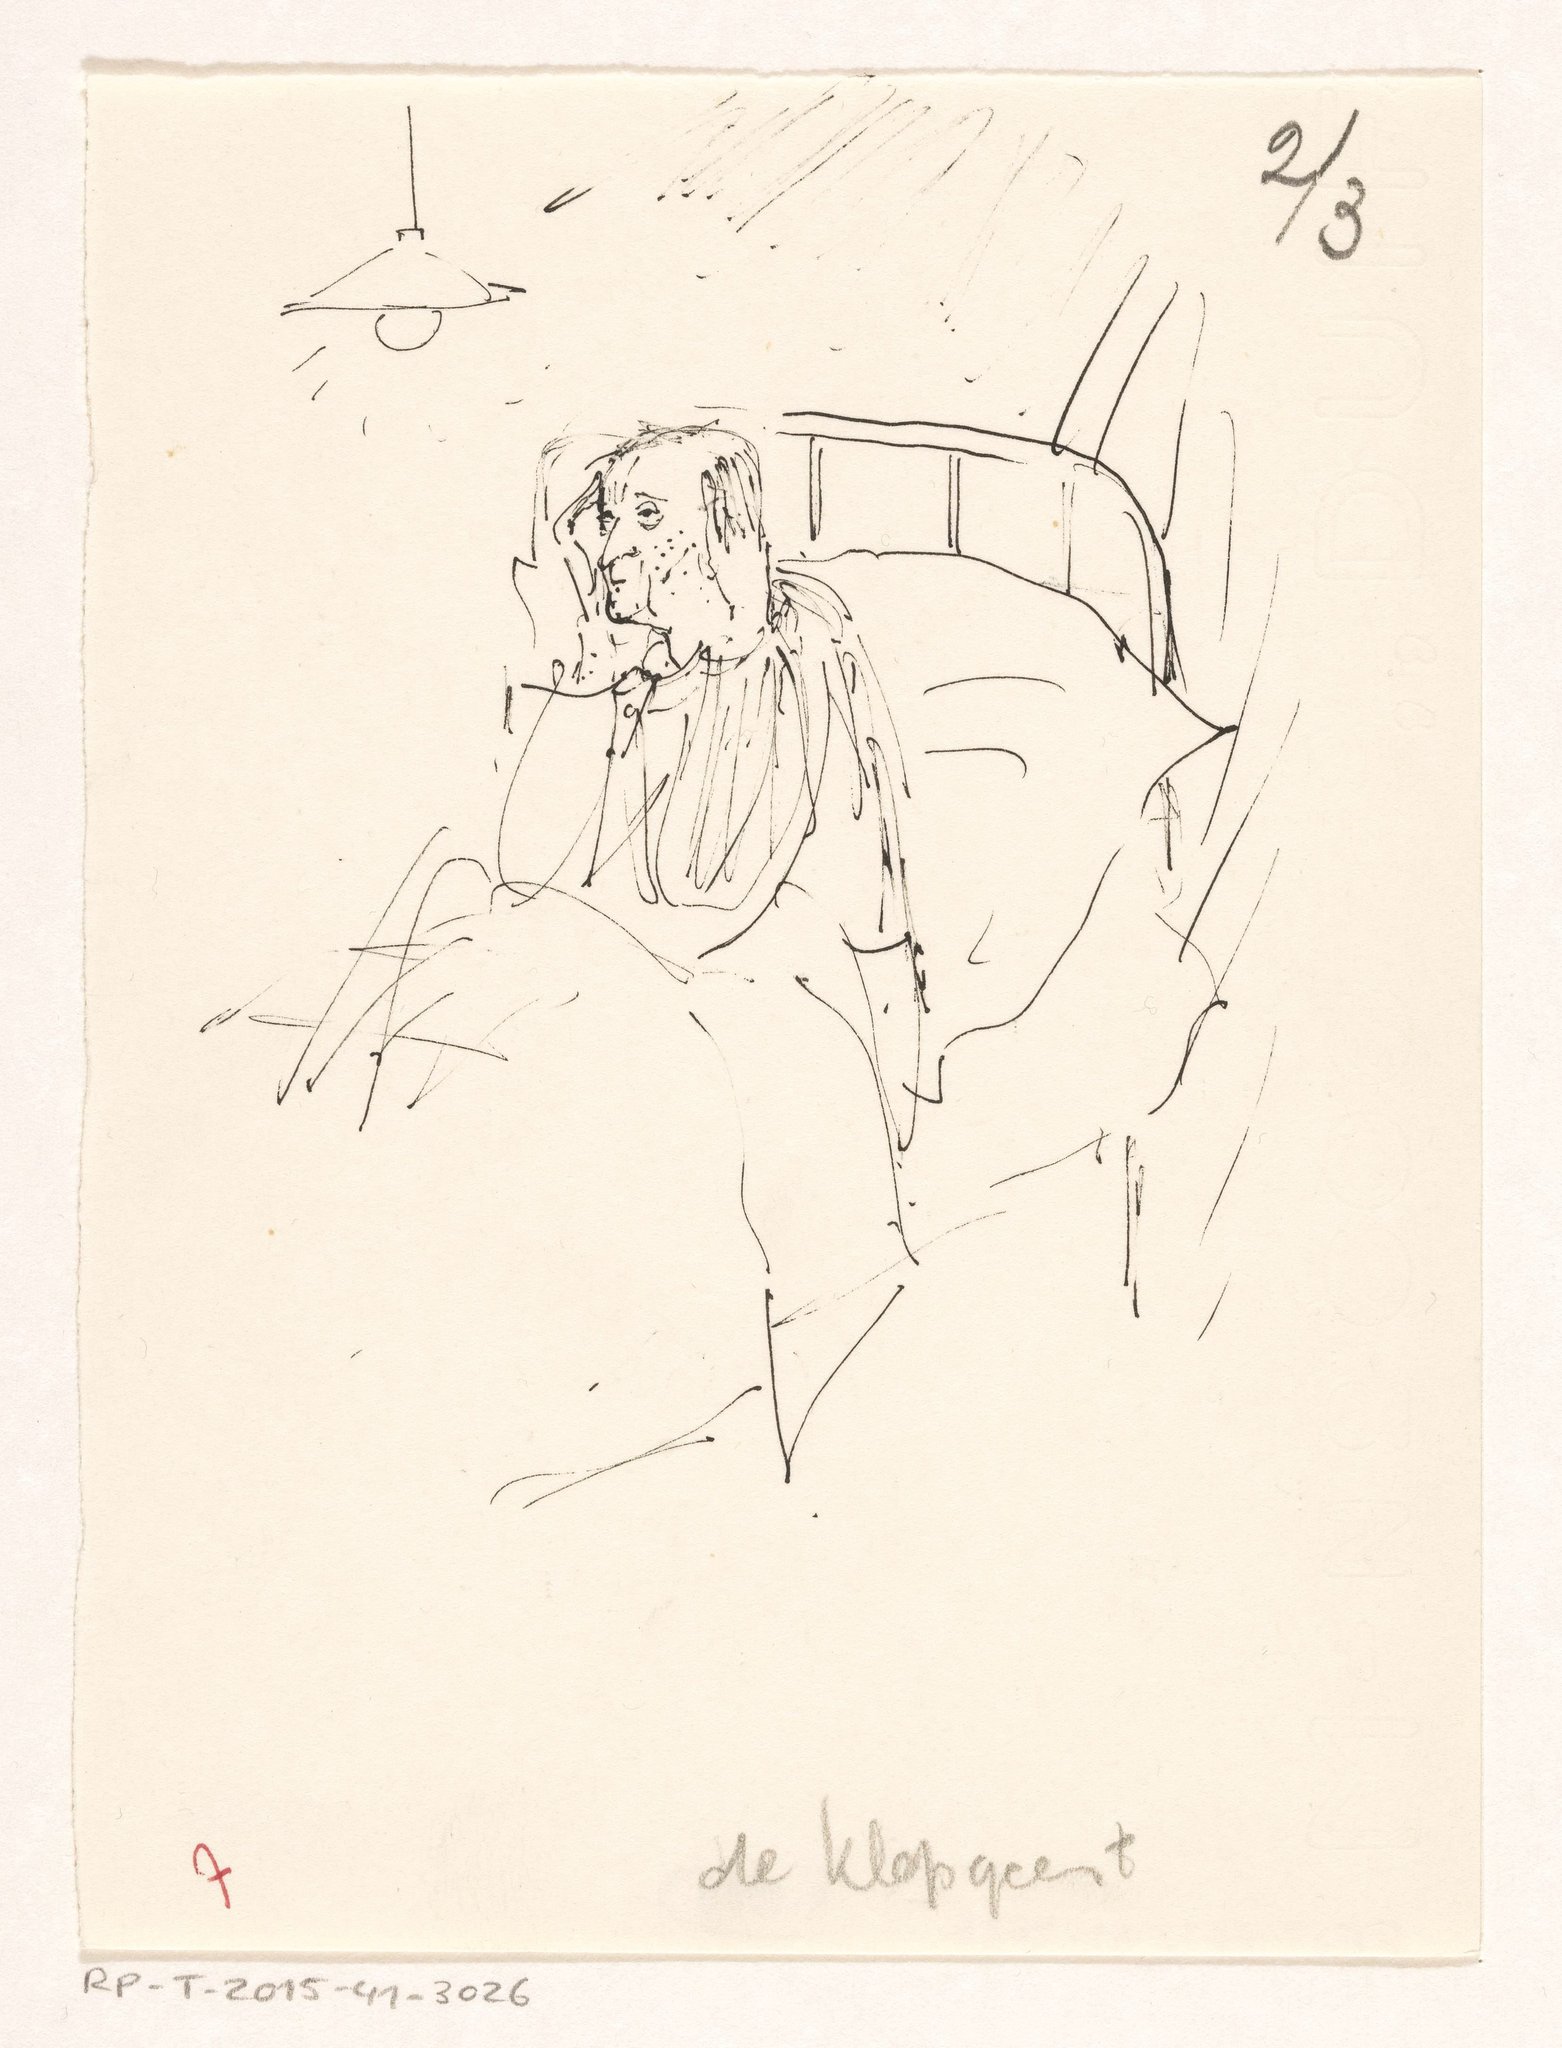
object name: boekillustratie ontwerp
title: Zittende man in bed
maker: Anonymous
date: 1930-1970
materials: ink, paper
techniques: pen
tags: hand(s) towards the ear(s) - aa - both arms or hands, bed, sitting figure (+ old male (human being))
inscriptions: :, annotation: ‘de klopgeest’, factory mark: ‘M - No 606 '' DUIF’, collector's mark: Lugt 2228a, number: ‘7’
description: Een oudere man zit in zijn pyjama rechtop in bed en houdt zijn handen tegen zijn oren.